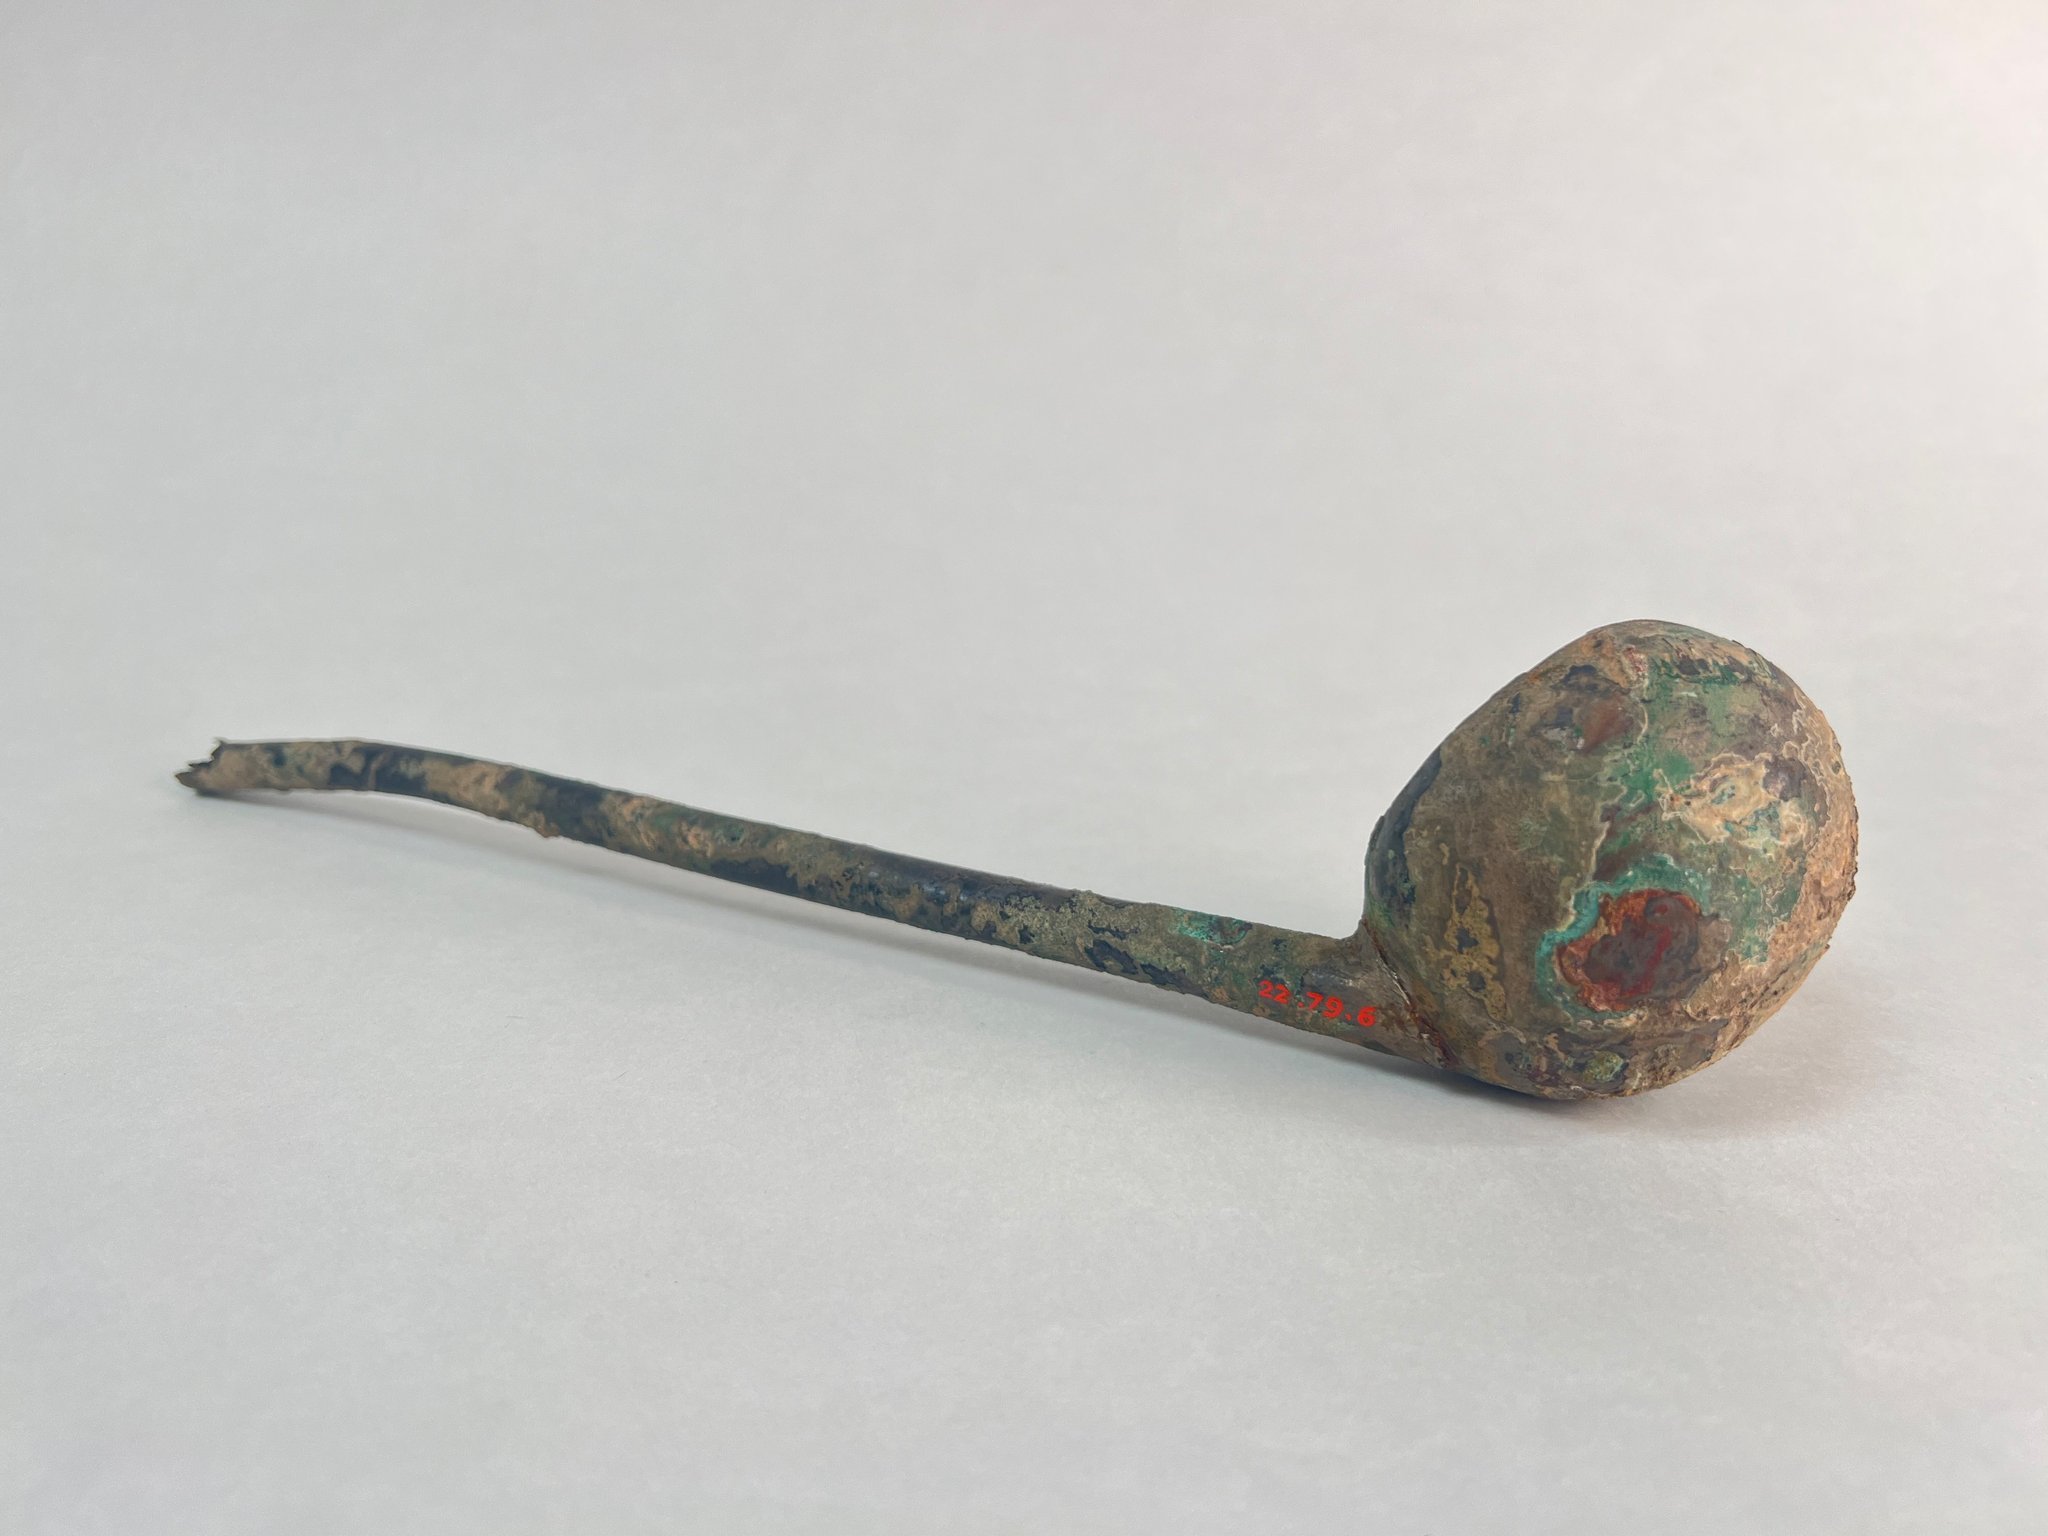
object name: ladle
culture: chinese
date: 618-907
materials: metal, silver